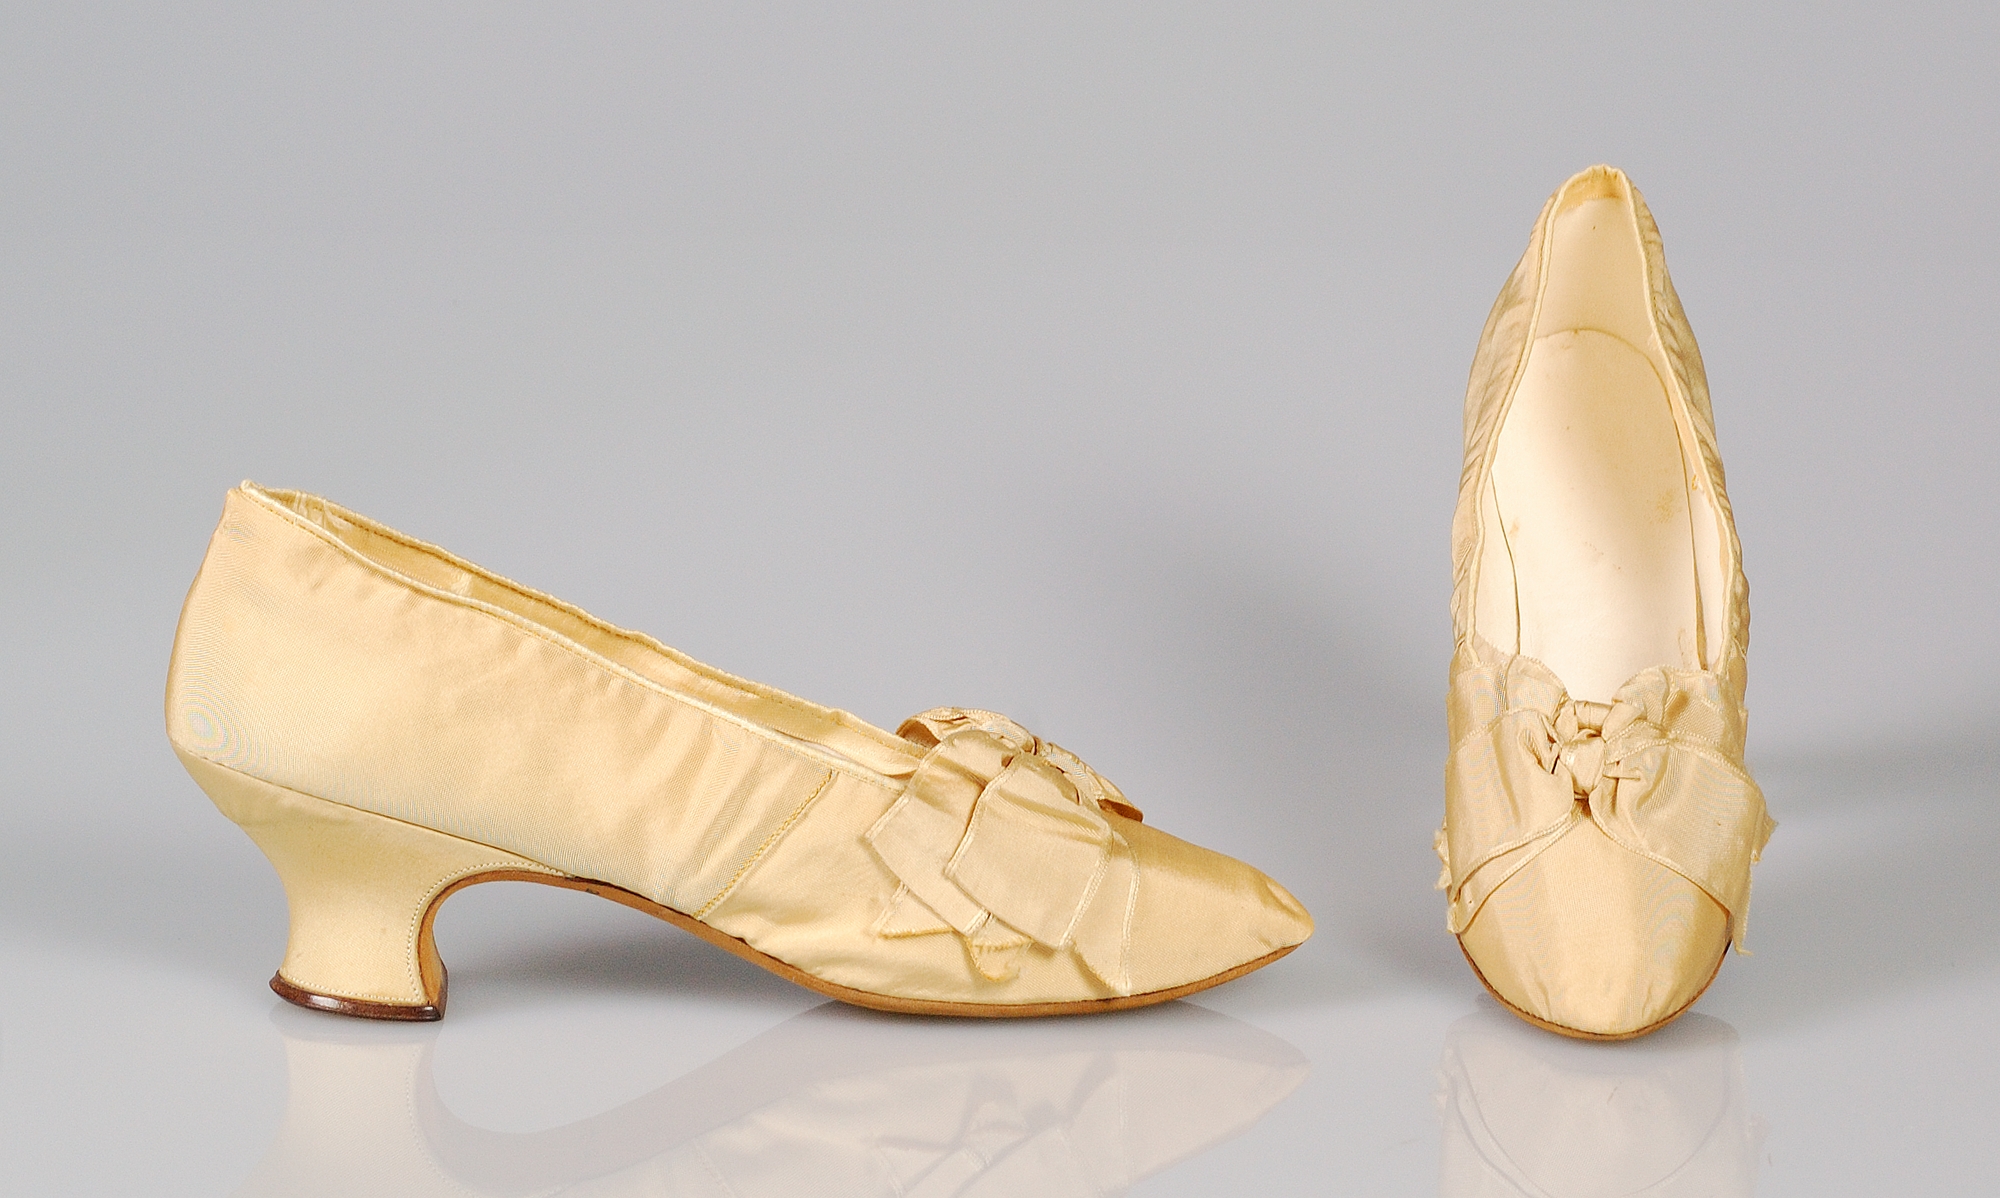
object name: evening shoe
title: Evening shoes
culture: french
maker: j. ferry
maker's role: maker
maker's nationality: french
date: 1880-1890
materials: silk